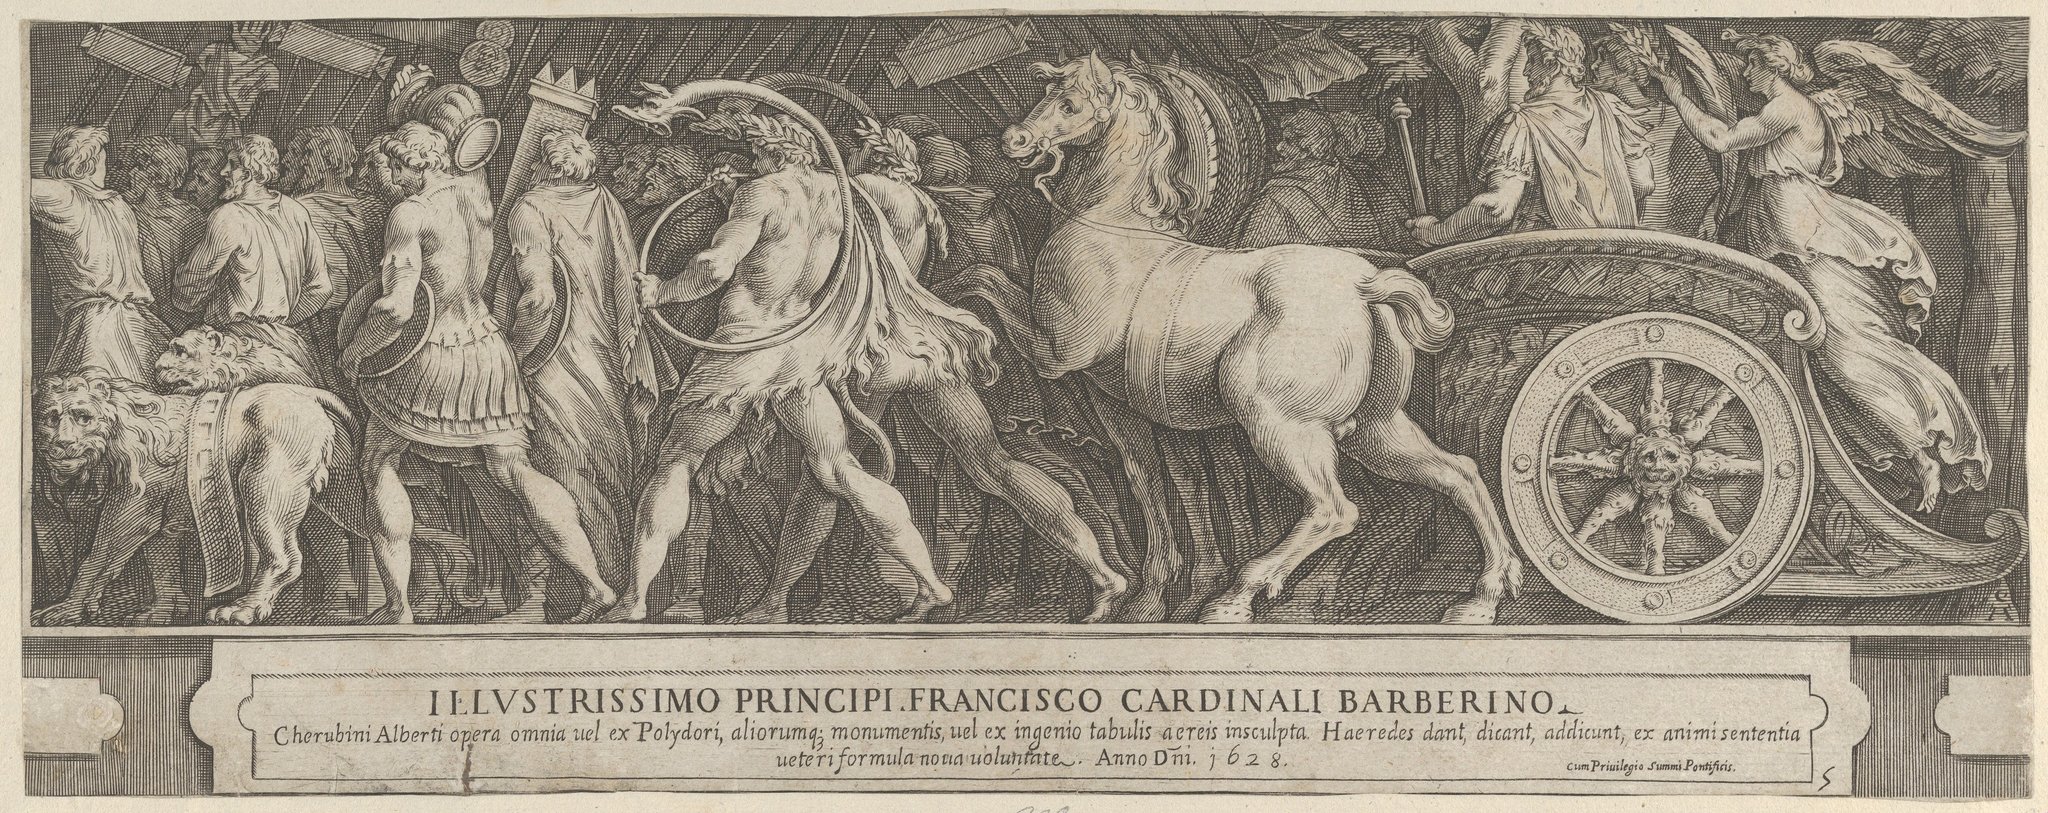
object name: print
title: The Triumph of Two Roman Emperors (left-hand side) with a Roman Emperor riding in a triumphal chariot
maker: cherubino alberti (zaccaria mattia)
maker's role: artist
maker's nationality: italian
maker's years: 1553-1615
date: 1570-1615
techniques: engraving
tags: emperors,men,mythical creatures,horses,lions,chariots